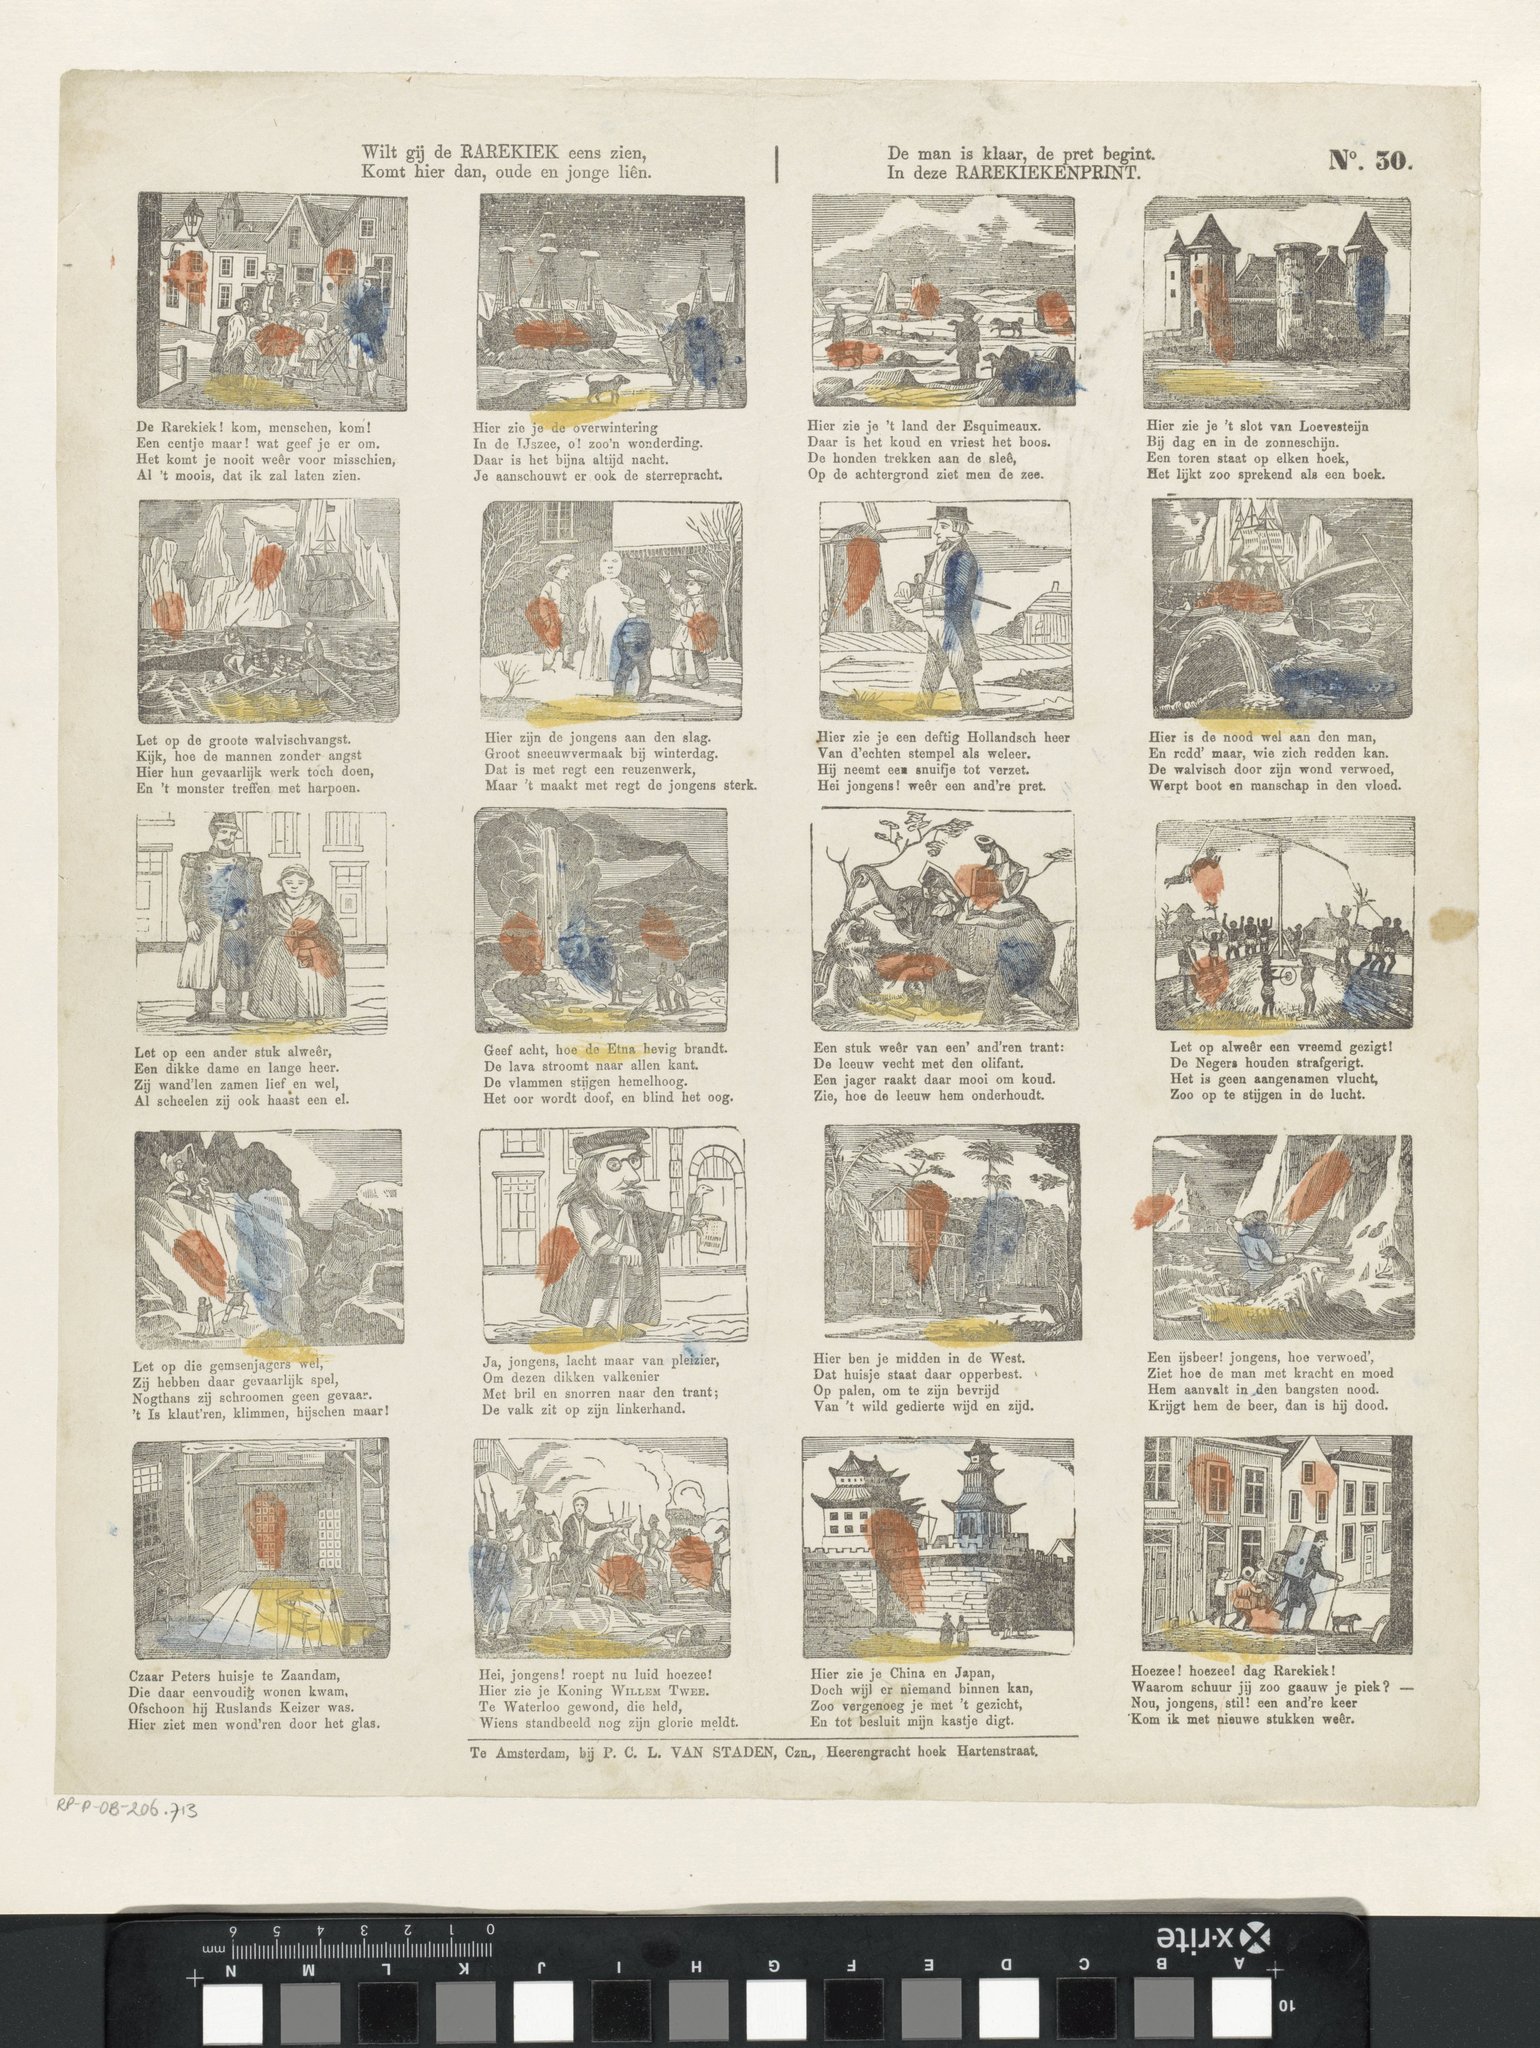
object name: popular print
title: Wilt gij de rarekiek eens zien, / Komt hier dan, oude en jonge liên. / De man is klaar, de pret begint, / In deze rarekiekenprint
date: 1850-1870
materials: paper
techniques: colour, letterpress printing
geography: netherlands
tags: (making a) snowman, drowning, shipwrecked person, trunked animals: elephant, swimming mammals: whale, loevestein castle, china, japan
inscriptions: collector's mark: Lugt 2760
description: Blad met 20 voorstellingen van verschillende aard, zoals voorstellingen van Slot Loevestein, van kinderen die een sneeuwpop maken en van een valkenier. Onder elke afbeelding een vierregelig vers. Genummerd rechtsboven: No. 30.